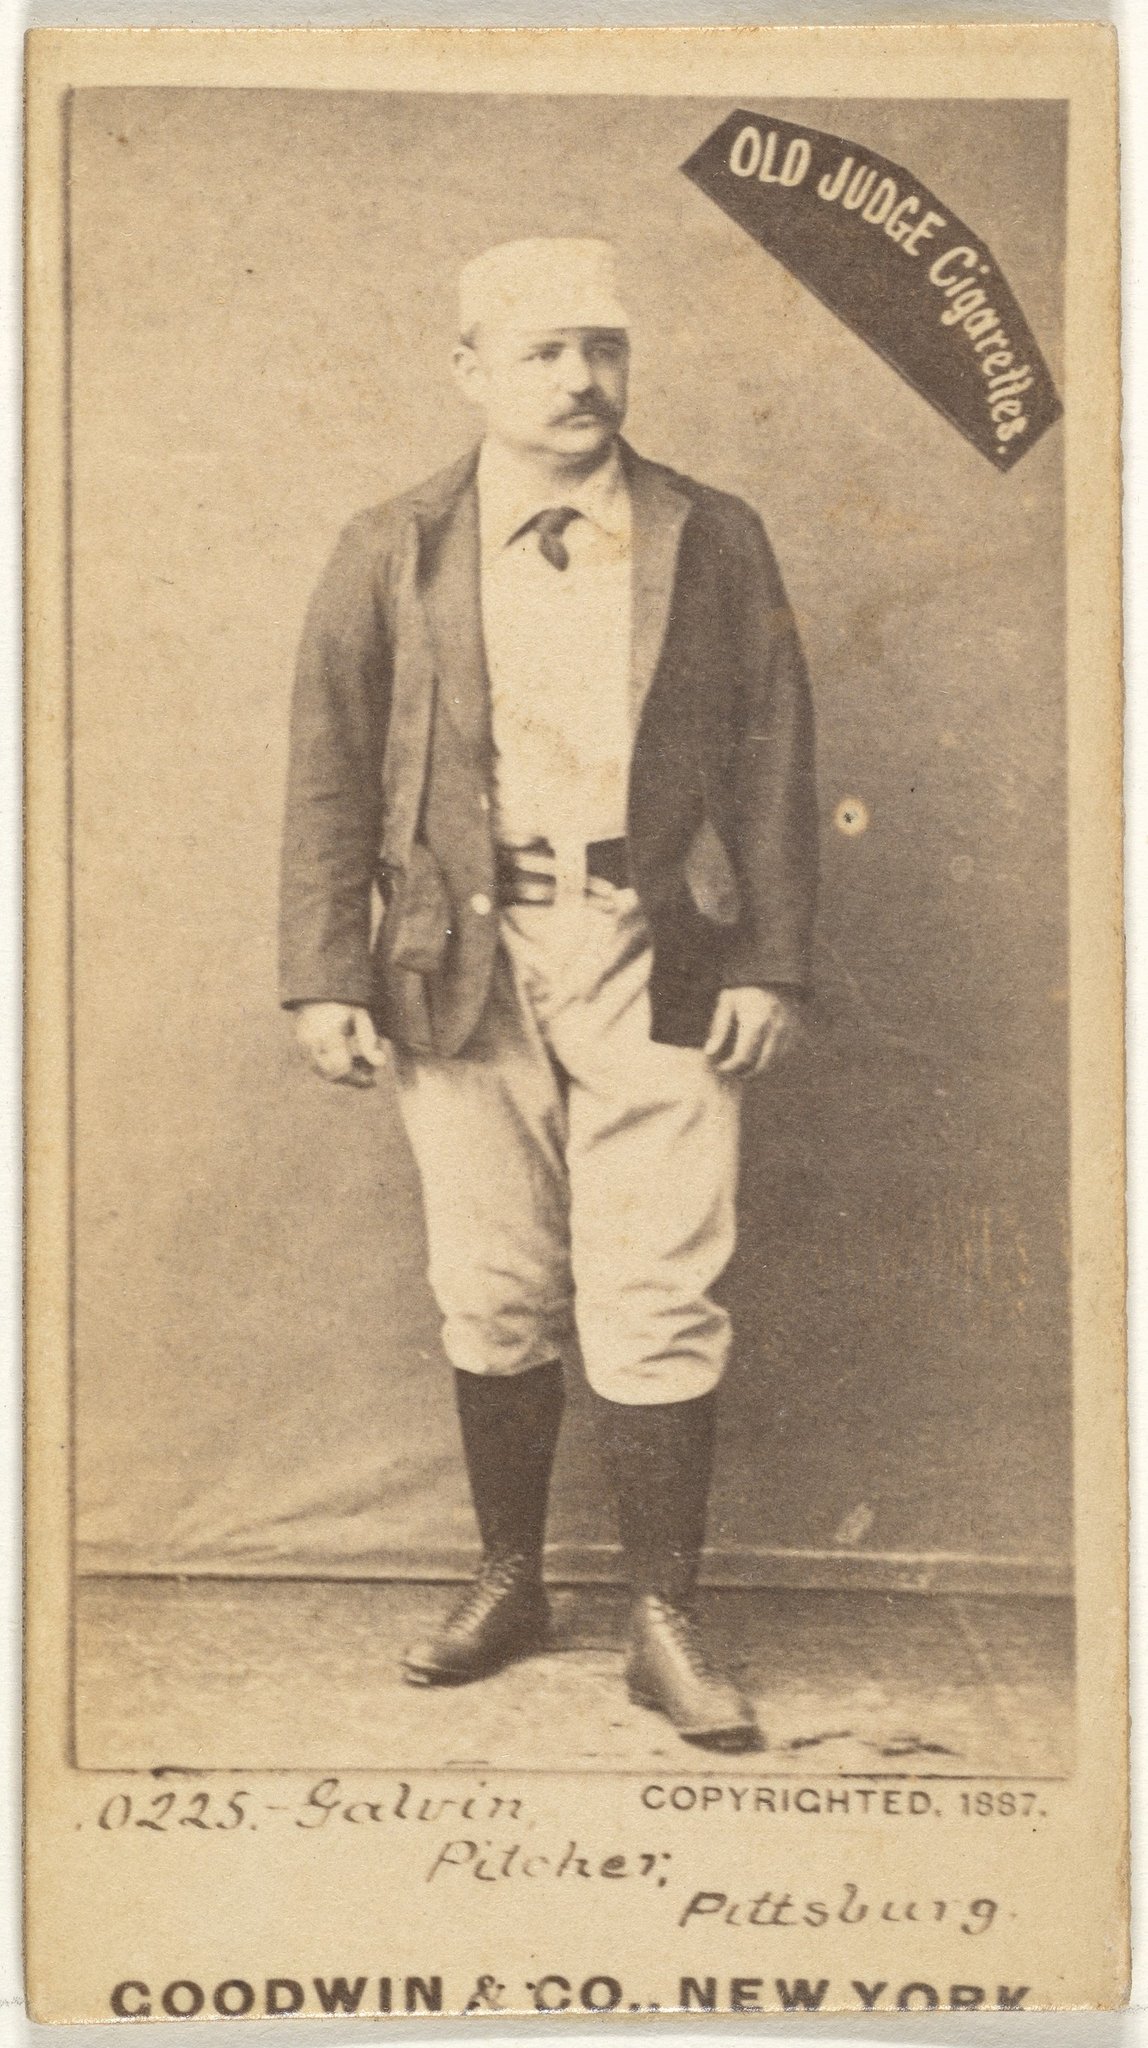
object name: baseball card, photograph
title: James Francis "Pud" Galvin, Pitcher, Pittsburgh, from the Old Judge series (N172) for Old Judge Cigarettes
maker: goodwin & company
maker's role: publisher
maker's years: 1850-1950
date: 1887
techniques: albumen silver print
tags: men,portraits,baseball,athletes